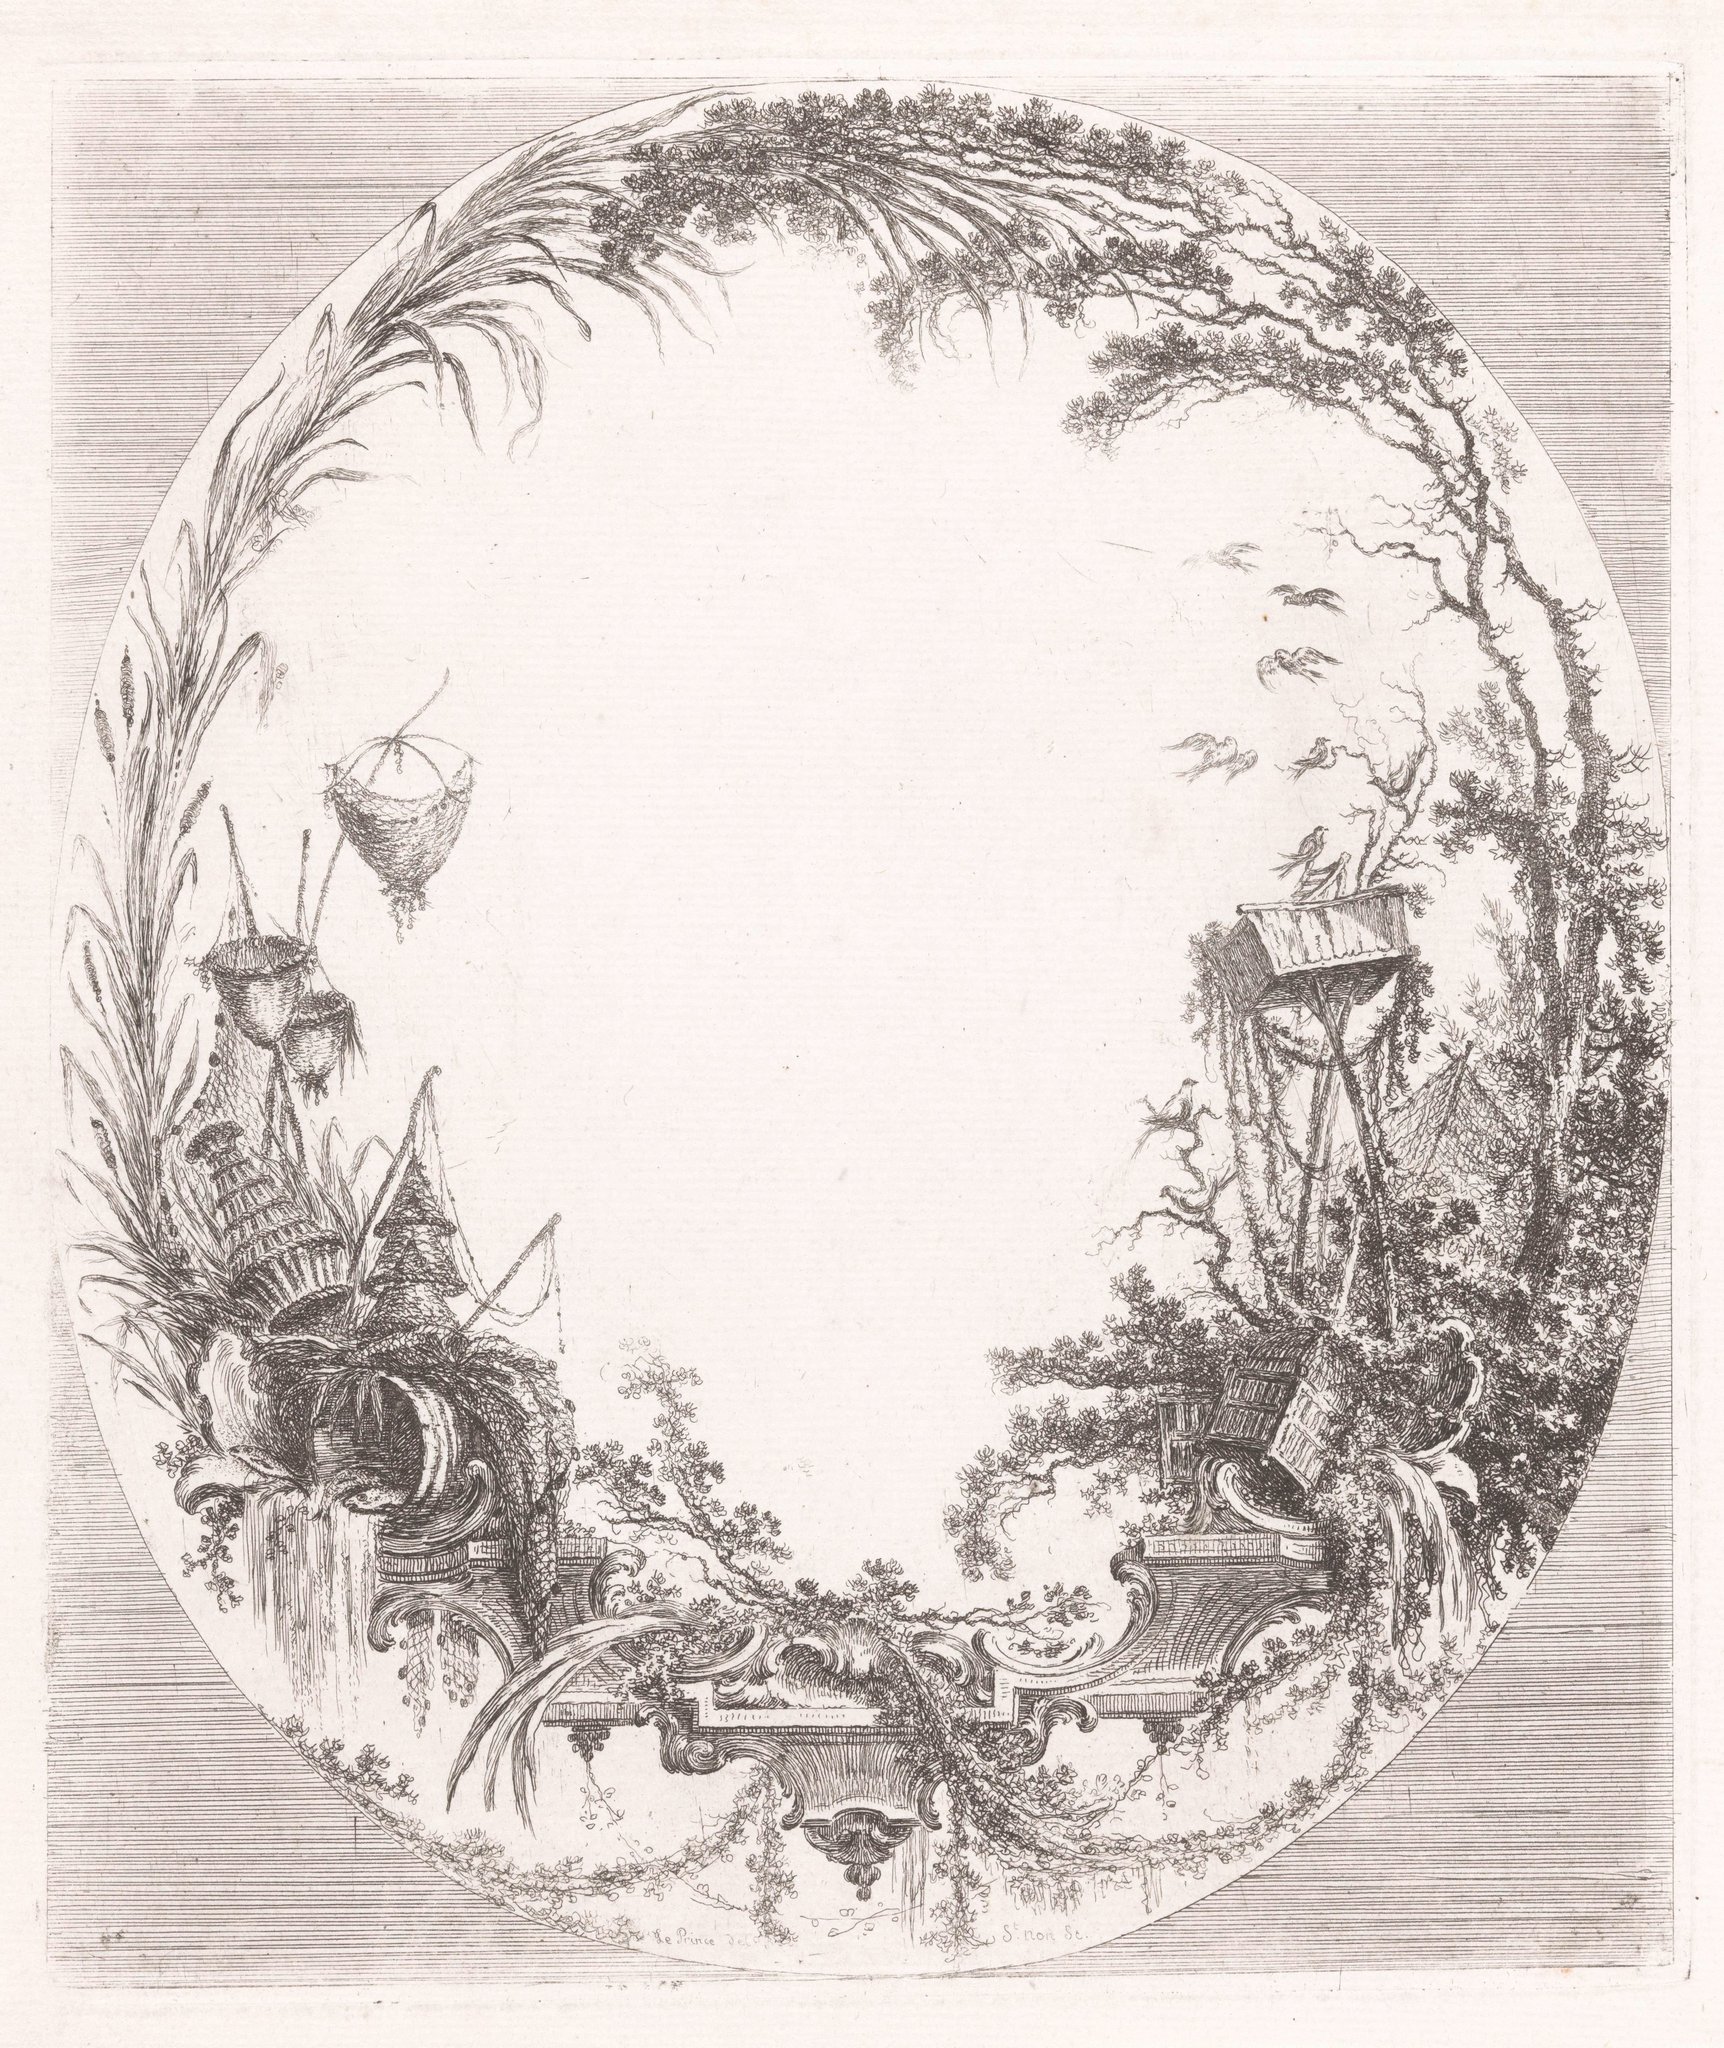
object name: print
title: Attributen van vissers en vogeljagers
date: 1744-1791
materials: paper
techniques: etching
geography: france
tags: bird hunting, fishing (sports)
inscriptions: collector's mark: Lugt 240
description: In een ovale omlijsting attributen van vissers en vogeljagers. Links lisdodden, visnetten, fuiken en een ton met vissen. Rechts een boom, vogels, een net en kooien. Midden boven hangt een mand met bloemen, midden onder dragen rocaille ornamenten de attributen.